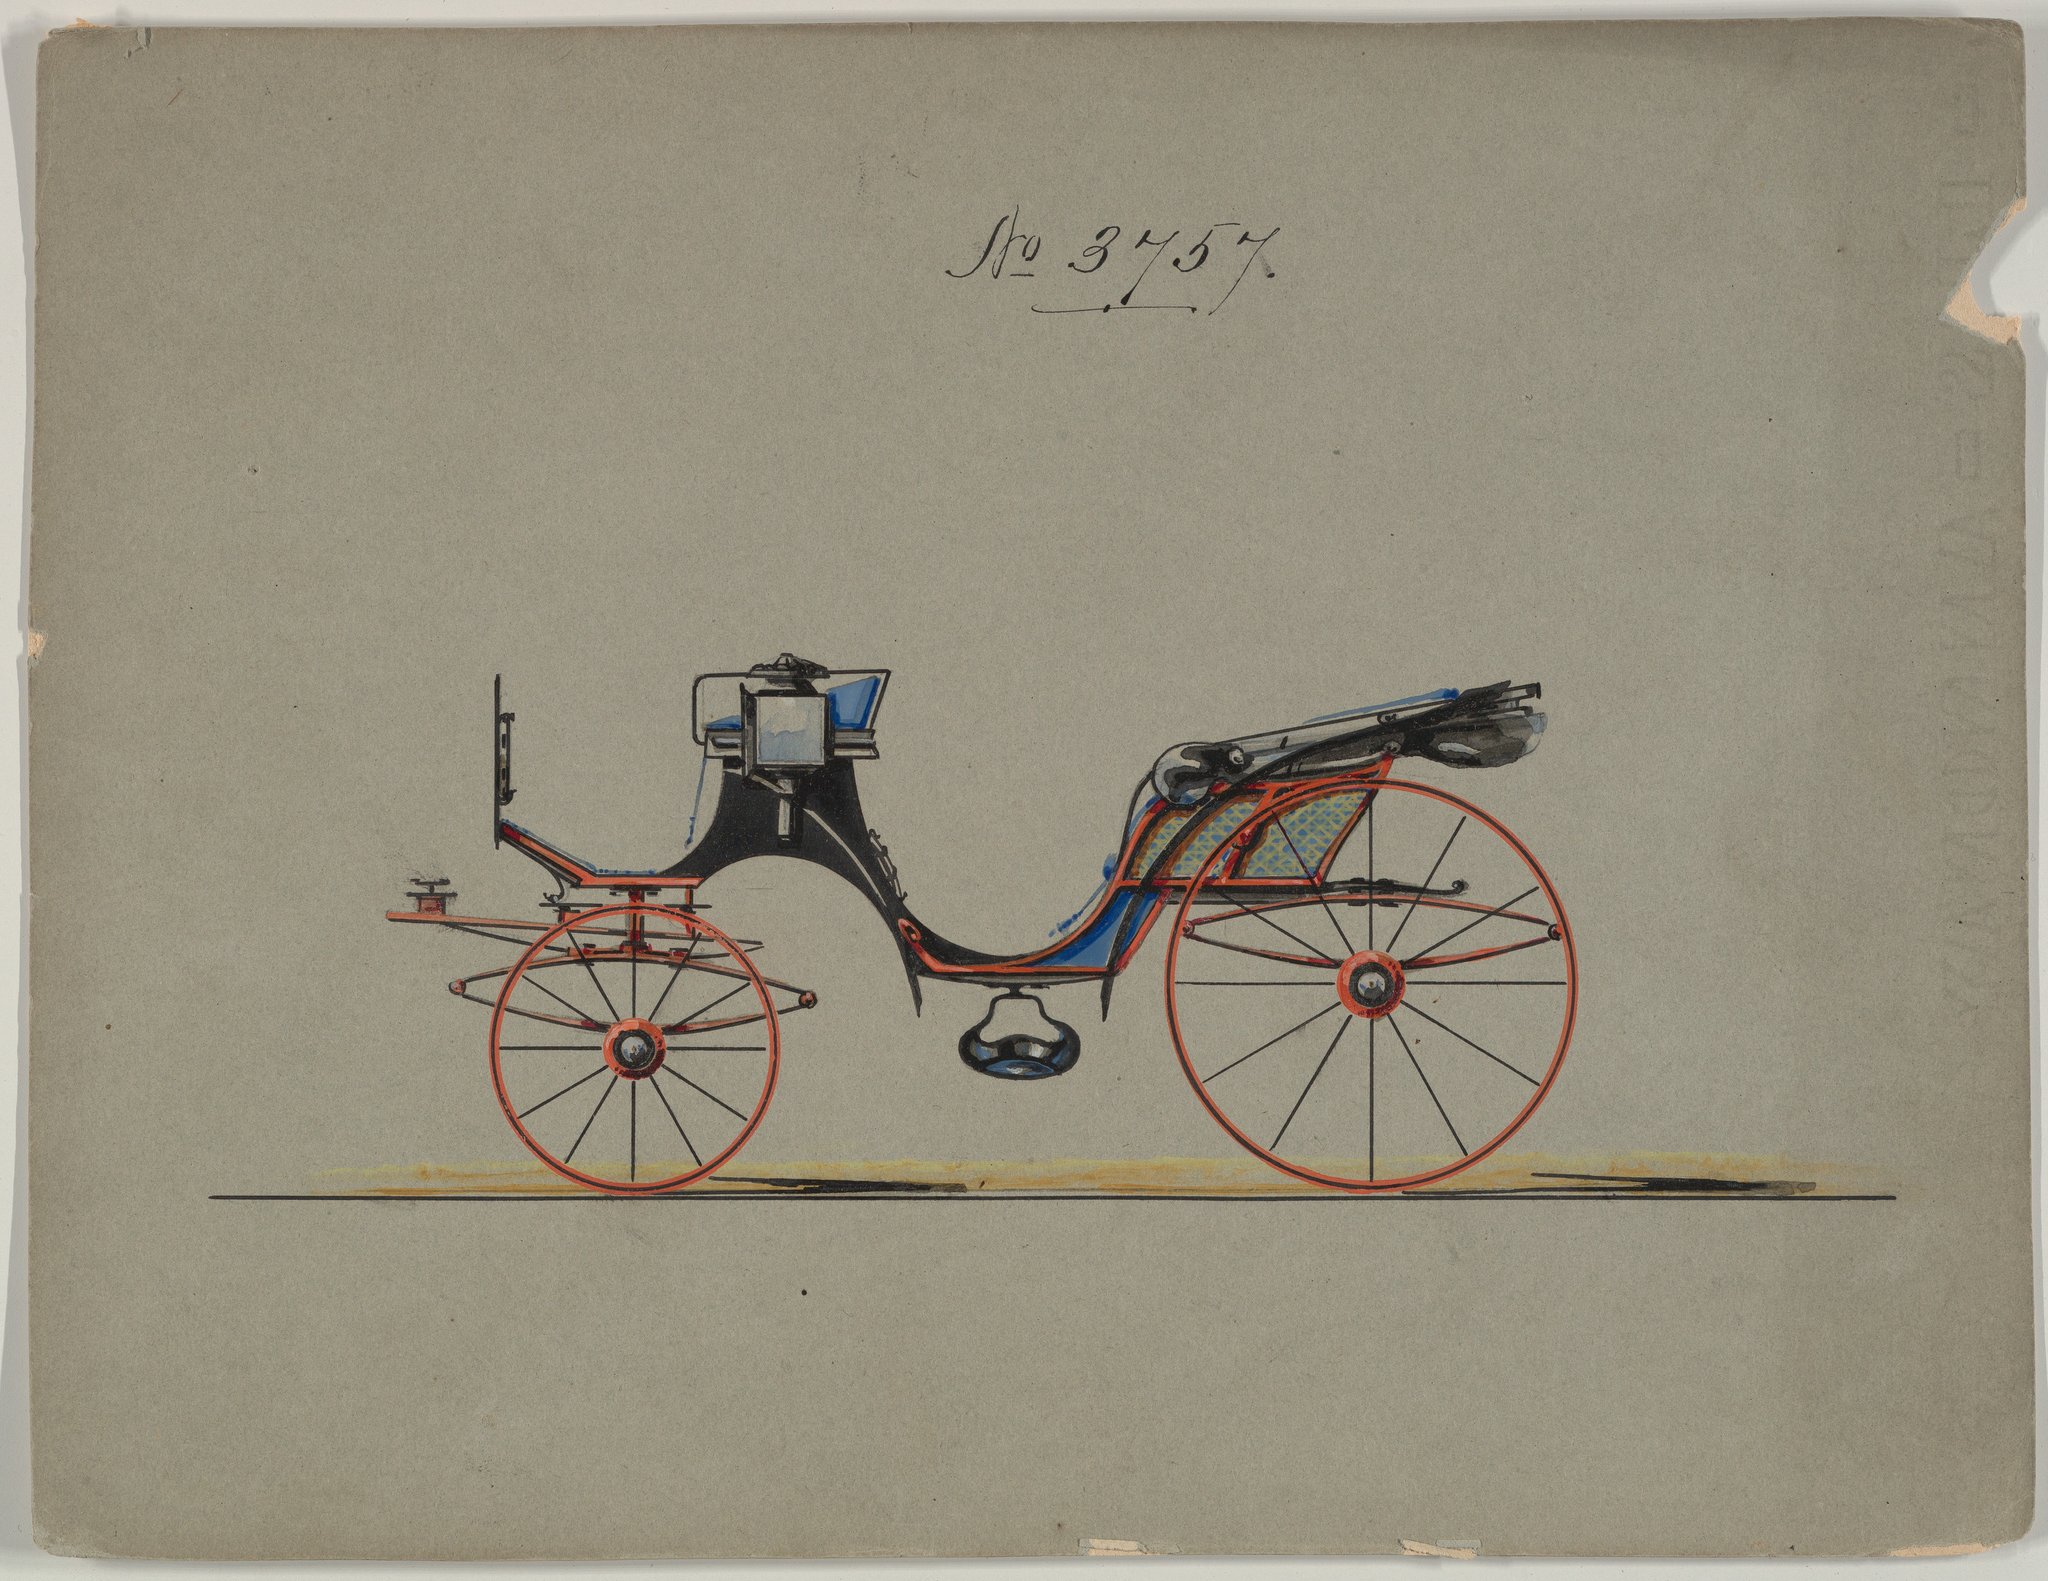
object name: drawing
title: Design for Cabriolet or Victoria, no. 3757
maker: brewster & co.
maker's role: manufacturer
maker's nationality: american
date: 1882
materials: gouache, ink, watercolor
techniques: pen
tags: carriages